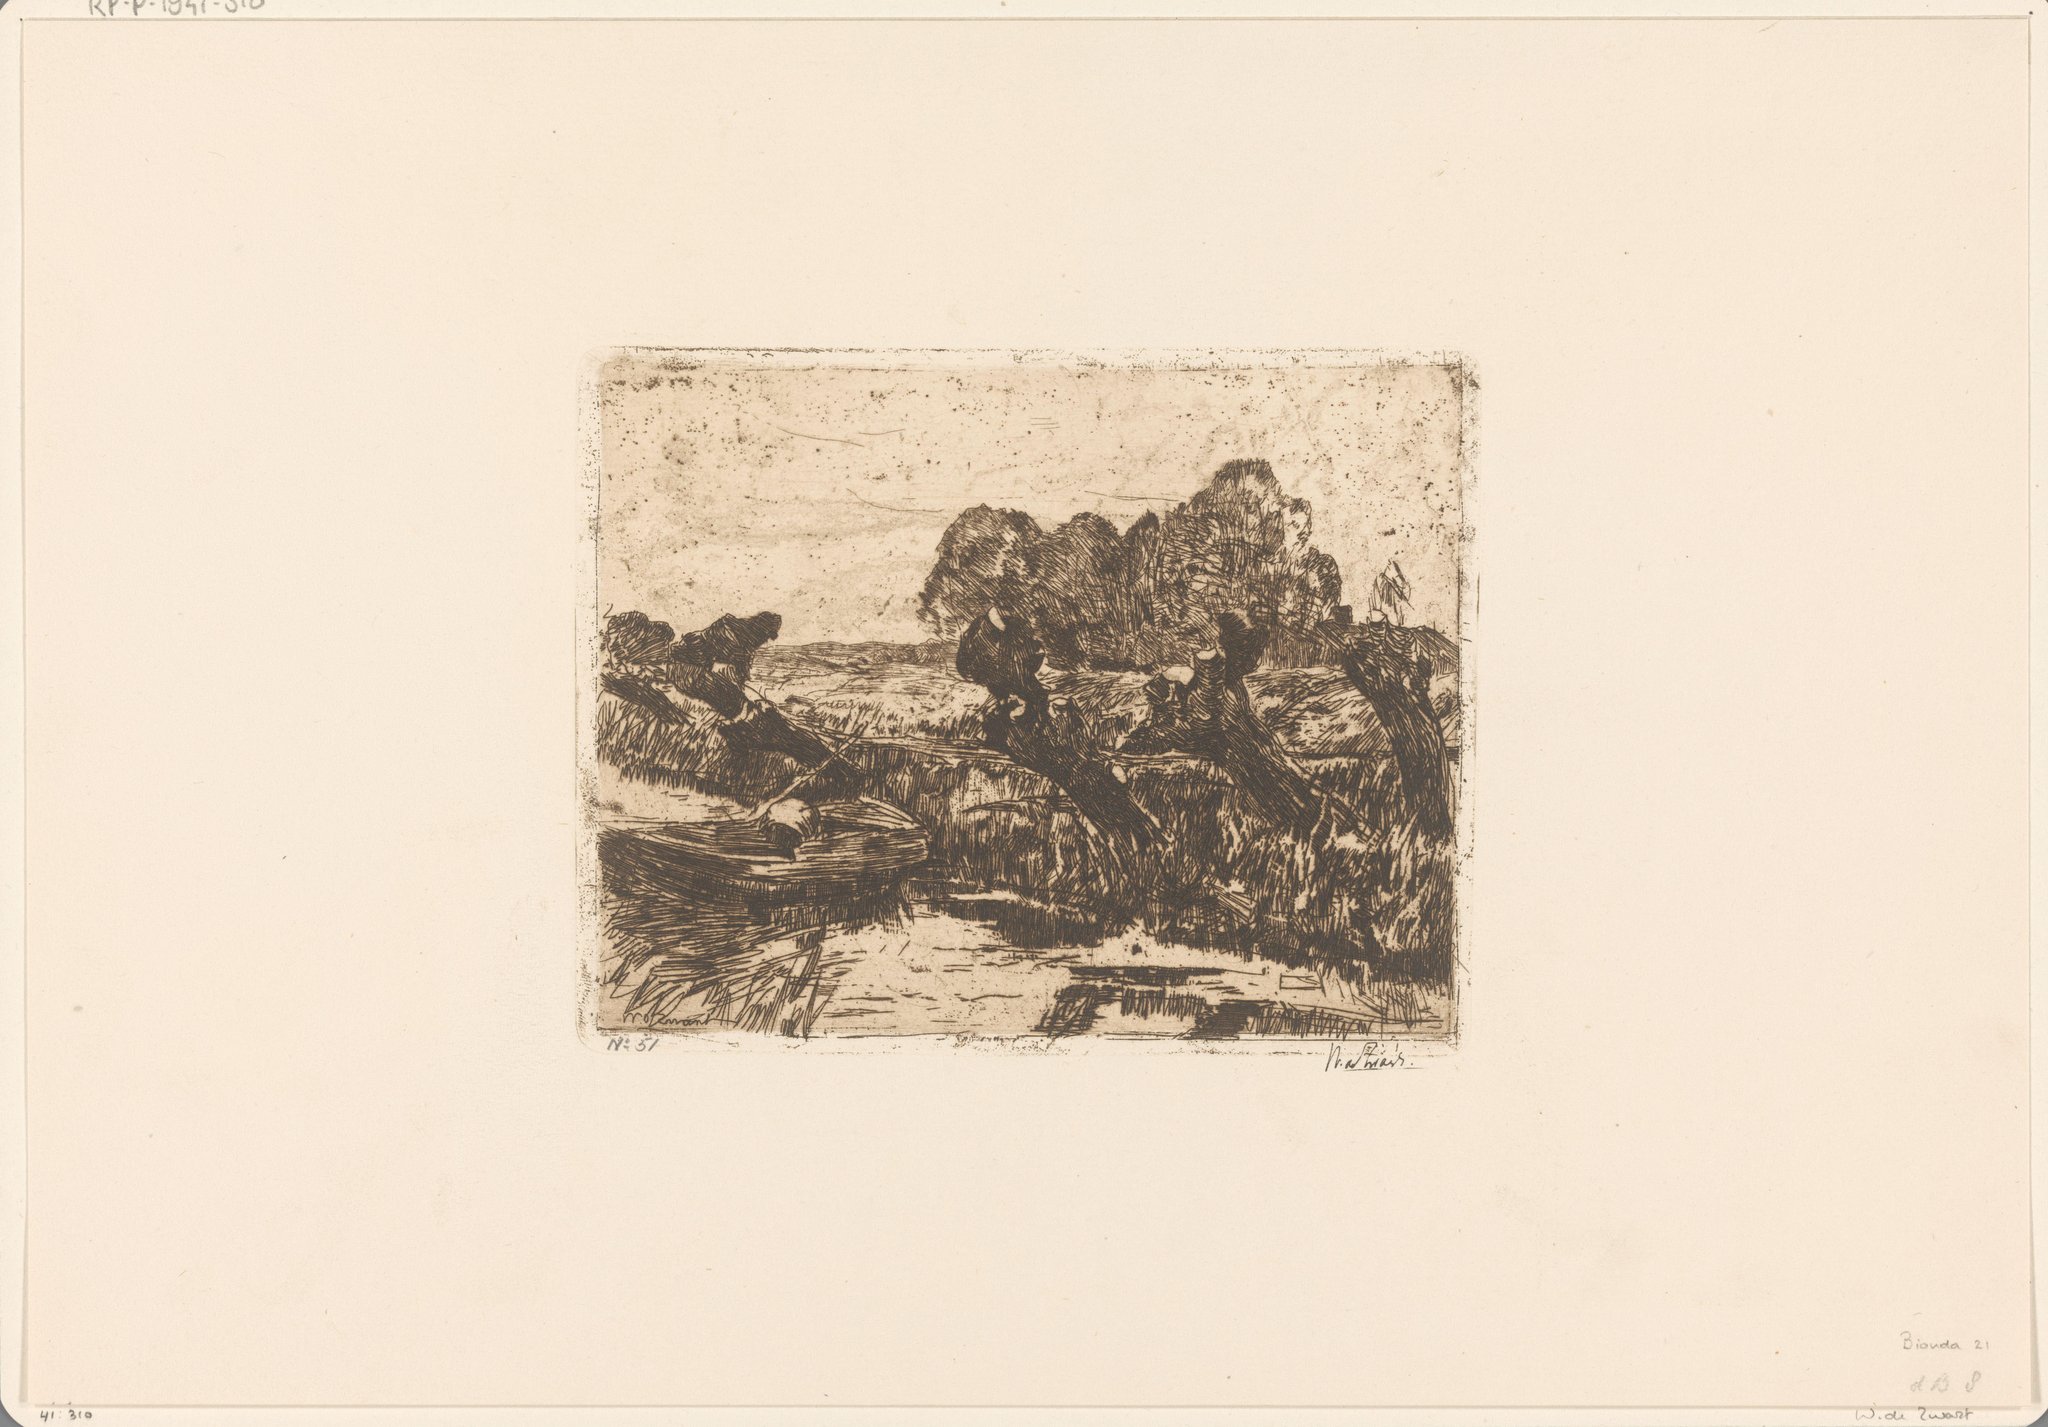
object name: print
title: Wilgen aan een sloot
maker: willem de zwart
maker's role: draughtsman, painter, print maker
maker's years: 1862-1931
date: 1885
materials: paper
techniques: drypoint, etching, intaglio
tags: rowing-boat, canoe, etc., trees: willow, small canal, ditch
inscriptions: collector's mark: Lugt 2760, collector's mark: Lugt 2228